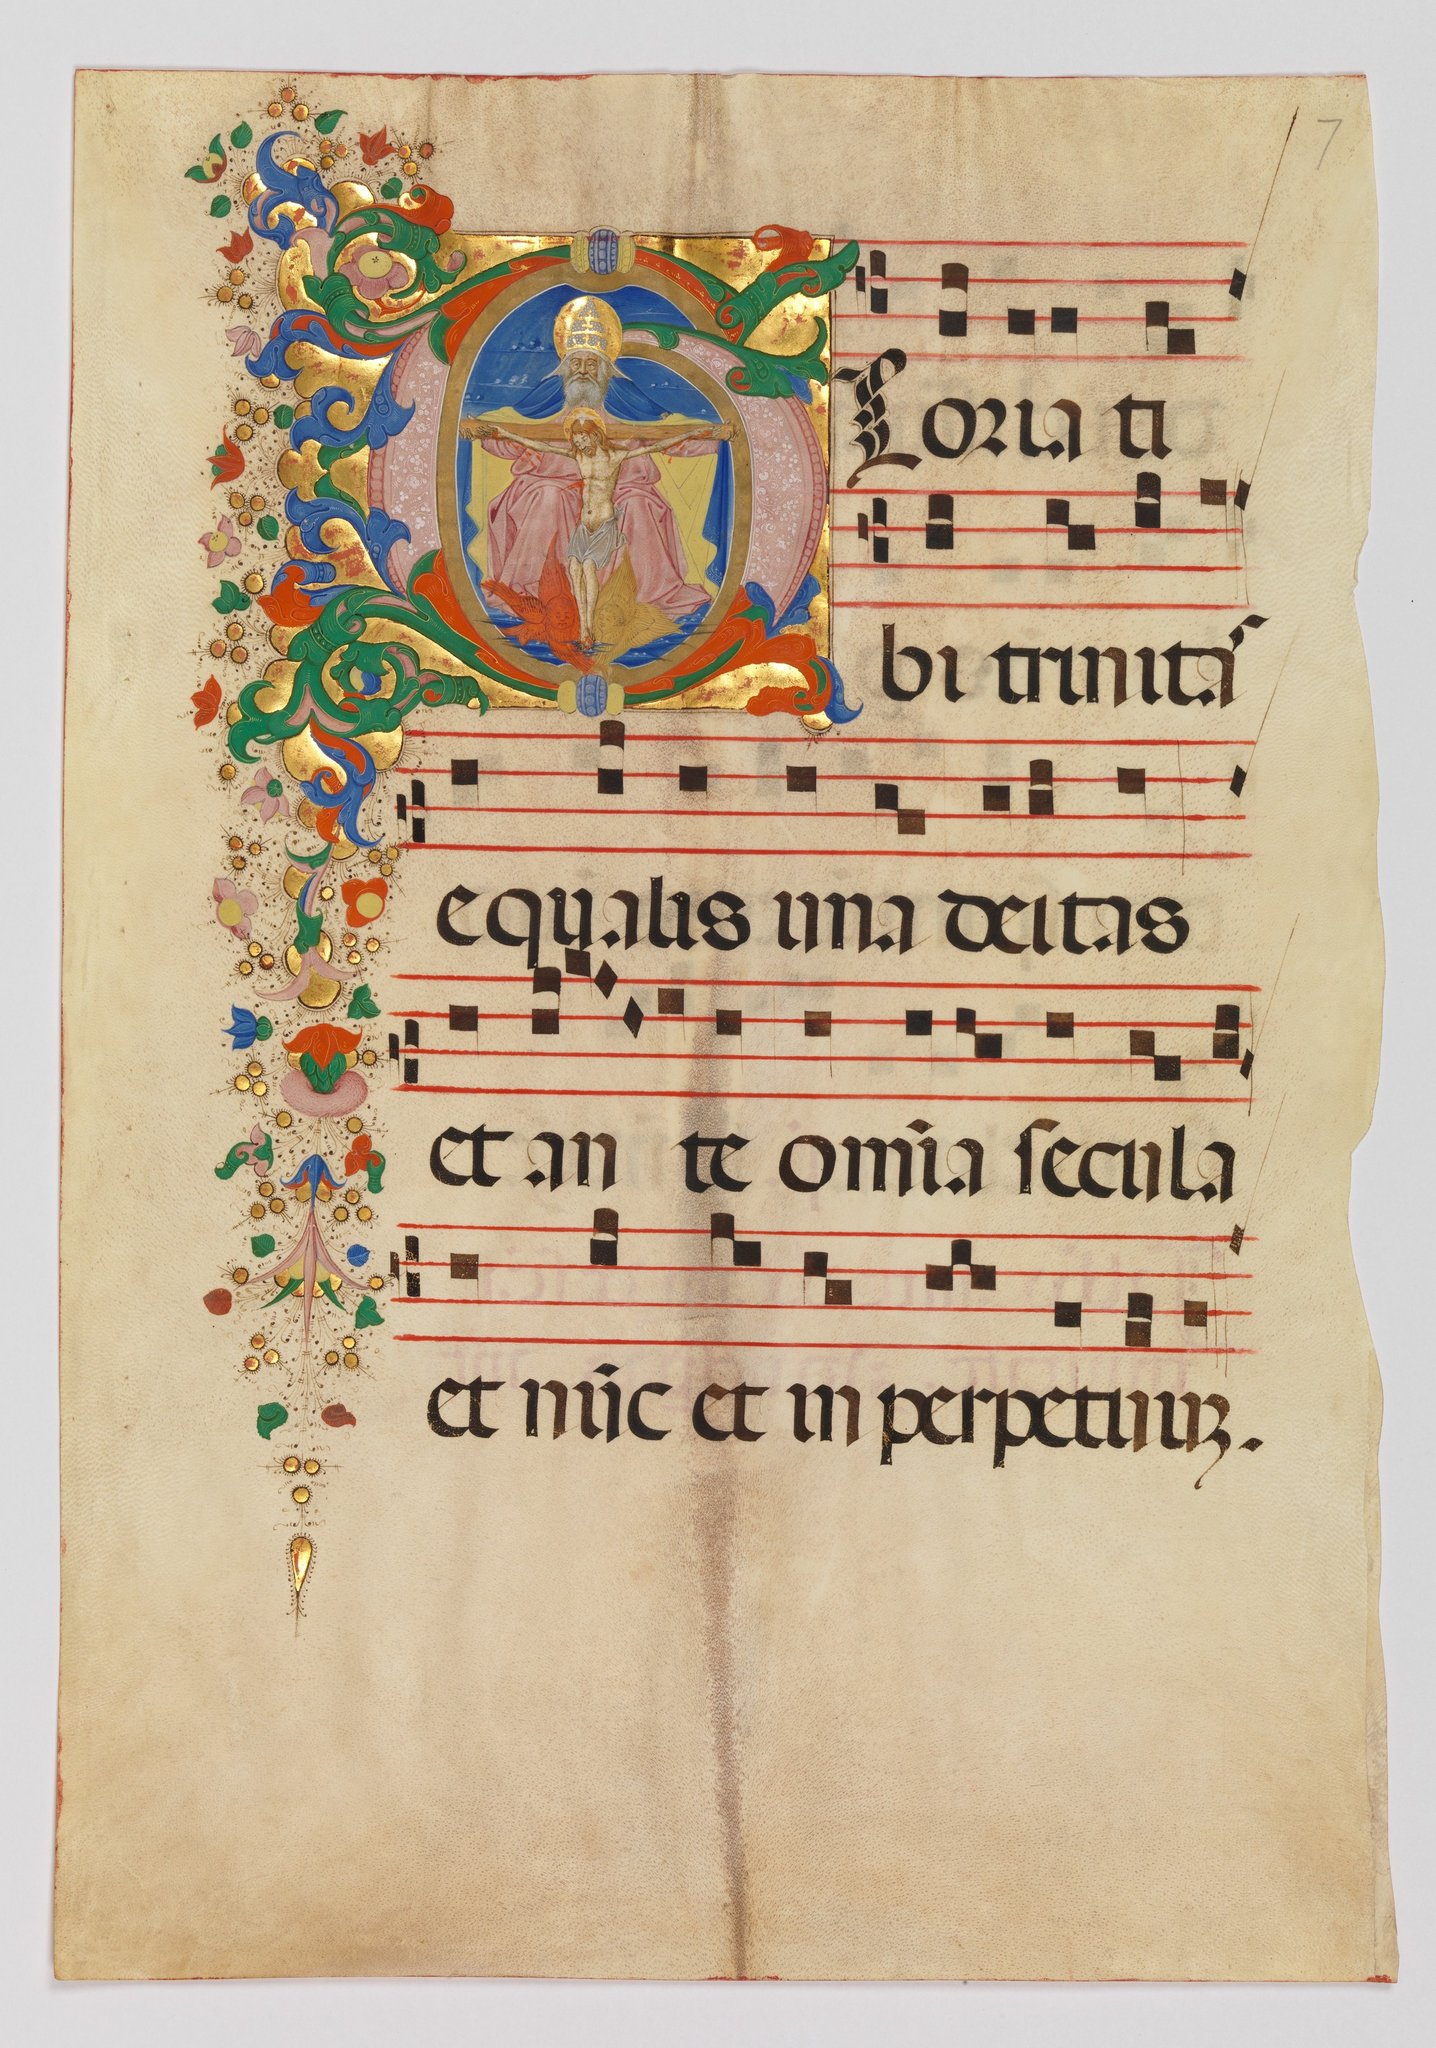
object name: antiphonary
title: Manuscript Leaf with the Trinity in an Initial G, from an Antiphonary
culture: italian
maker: master of the riccardiana lactantius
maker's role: artist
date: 1451-1500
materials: gold, ink, parchment, paint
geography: italy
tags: christ,crucifixion